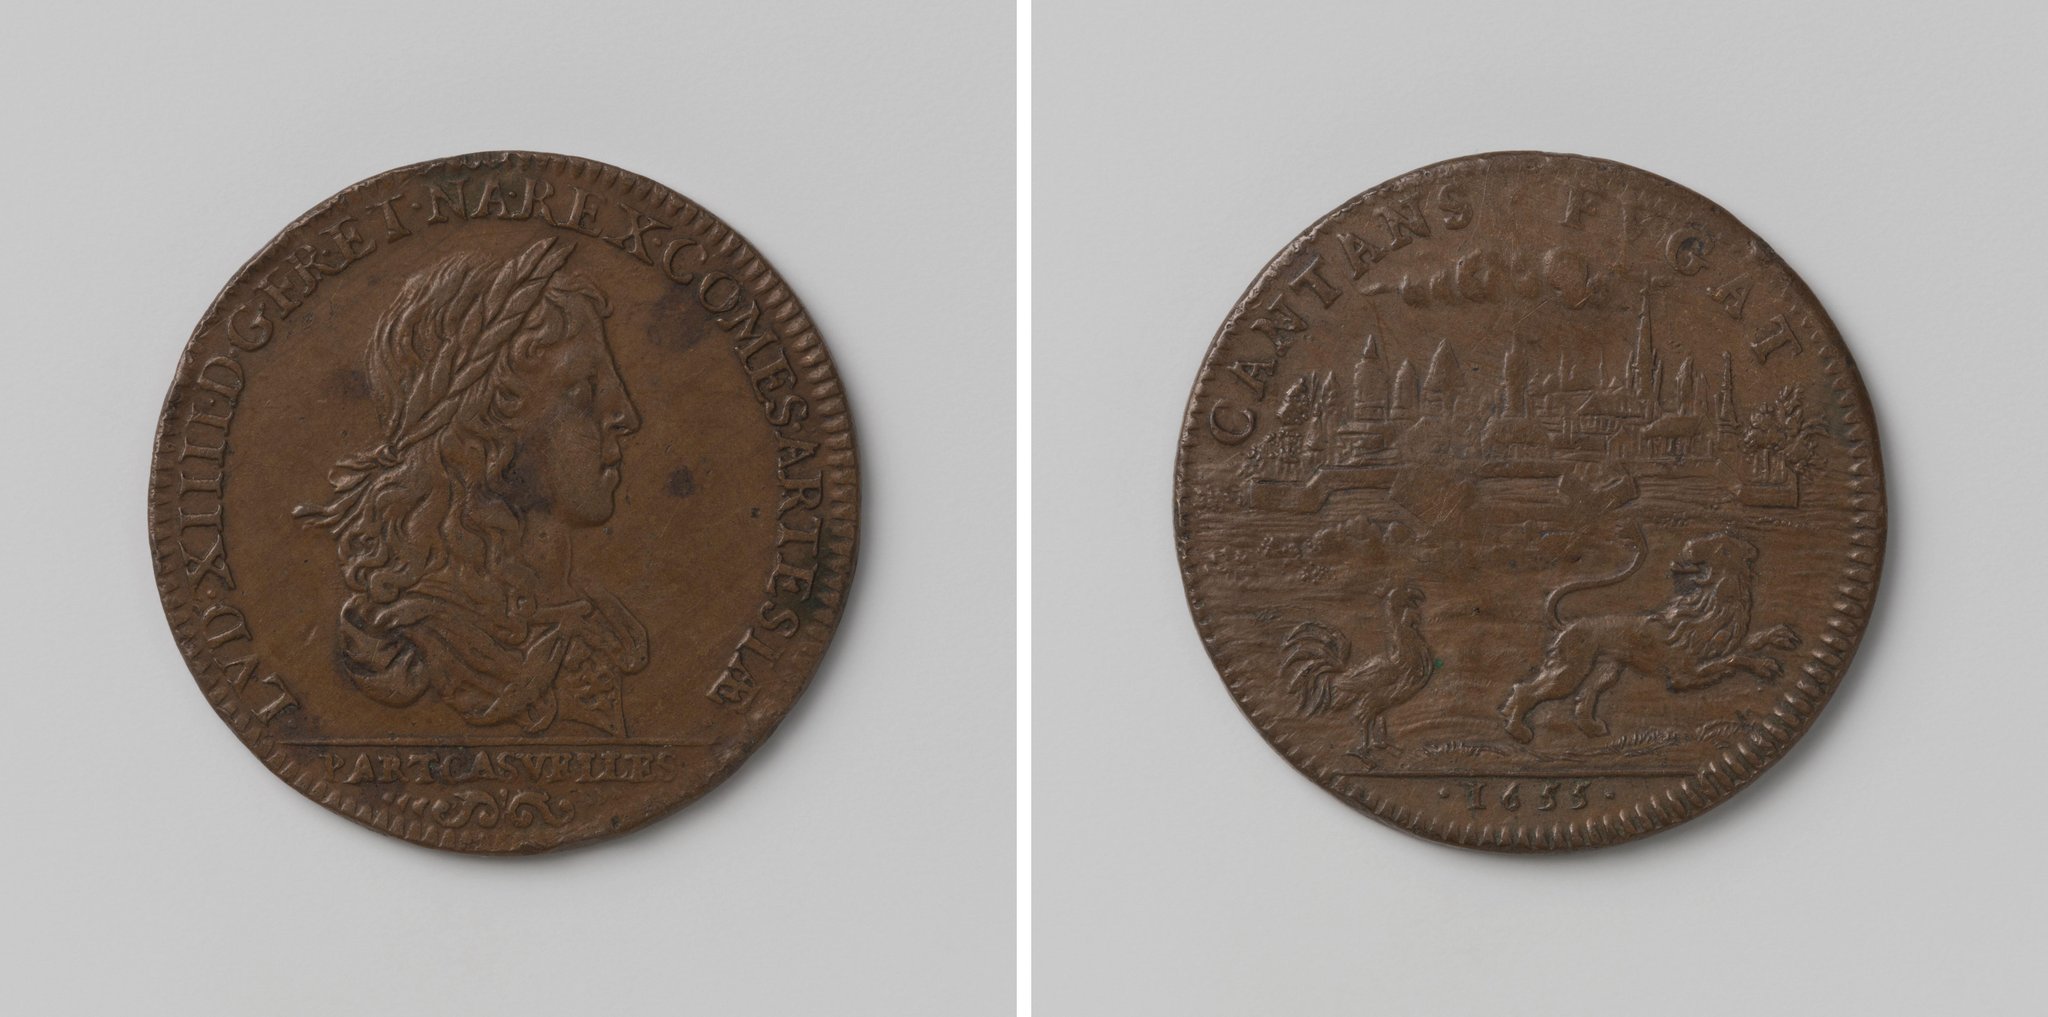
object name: jeton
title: Inname van Quesnoy, rekenpenning geslagen ter ere van Lodewijk XIV, koning van Frankrijk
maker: Anonymous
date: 1655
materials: copper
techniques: striking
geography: france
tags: lodewijk xiv (koning van frankrijk)